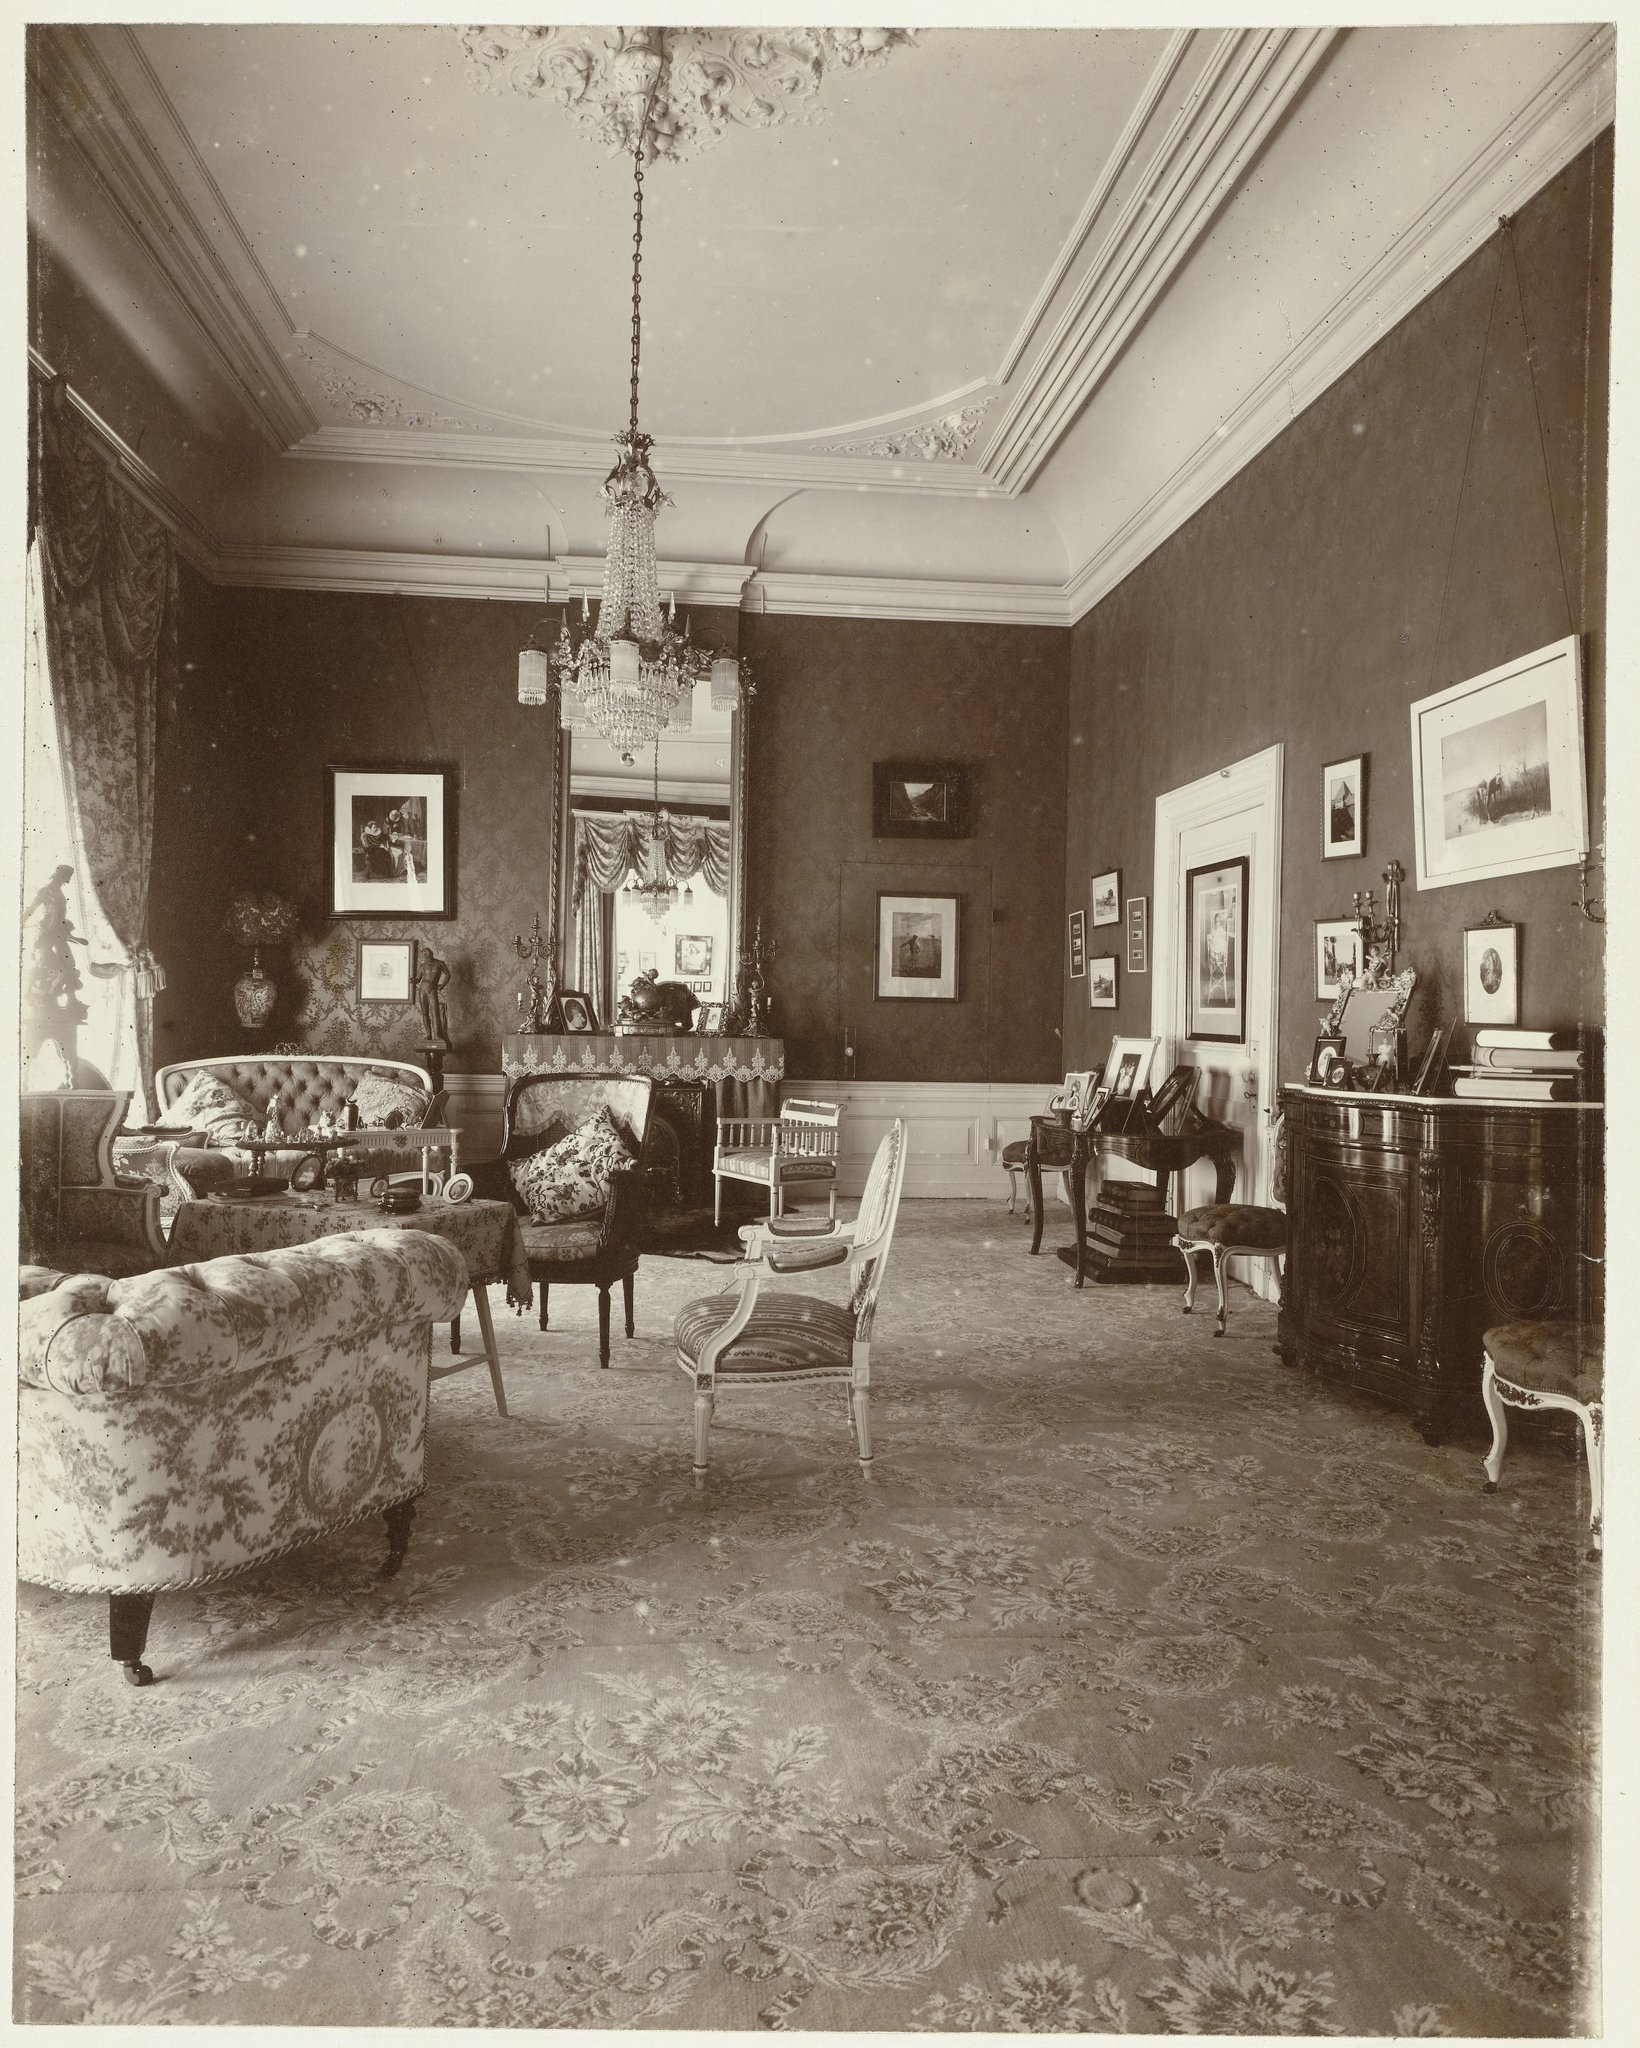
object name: photograph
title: Kamer met zithoek en salontafel in landgoed De Wildbaan, Driebergen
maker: henry pauw van wieldrecht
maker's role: fotograaf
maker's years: 1863-1912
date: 1903-1907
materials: paper, photographic support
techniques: gelatin silver print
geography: netherlands